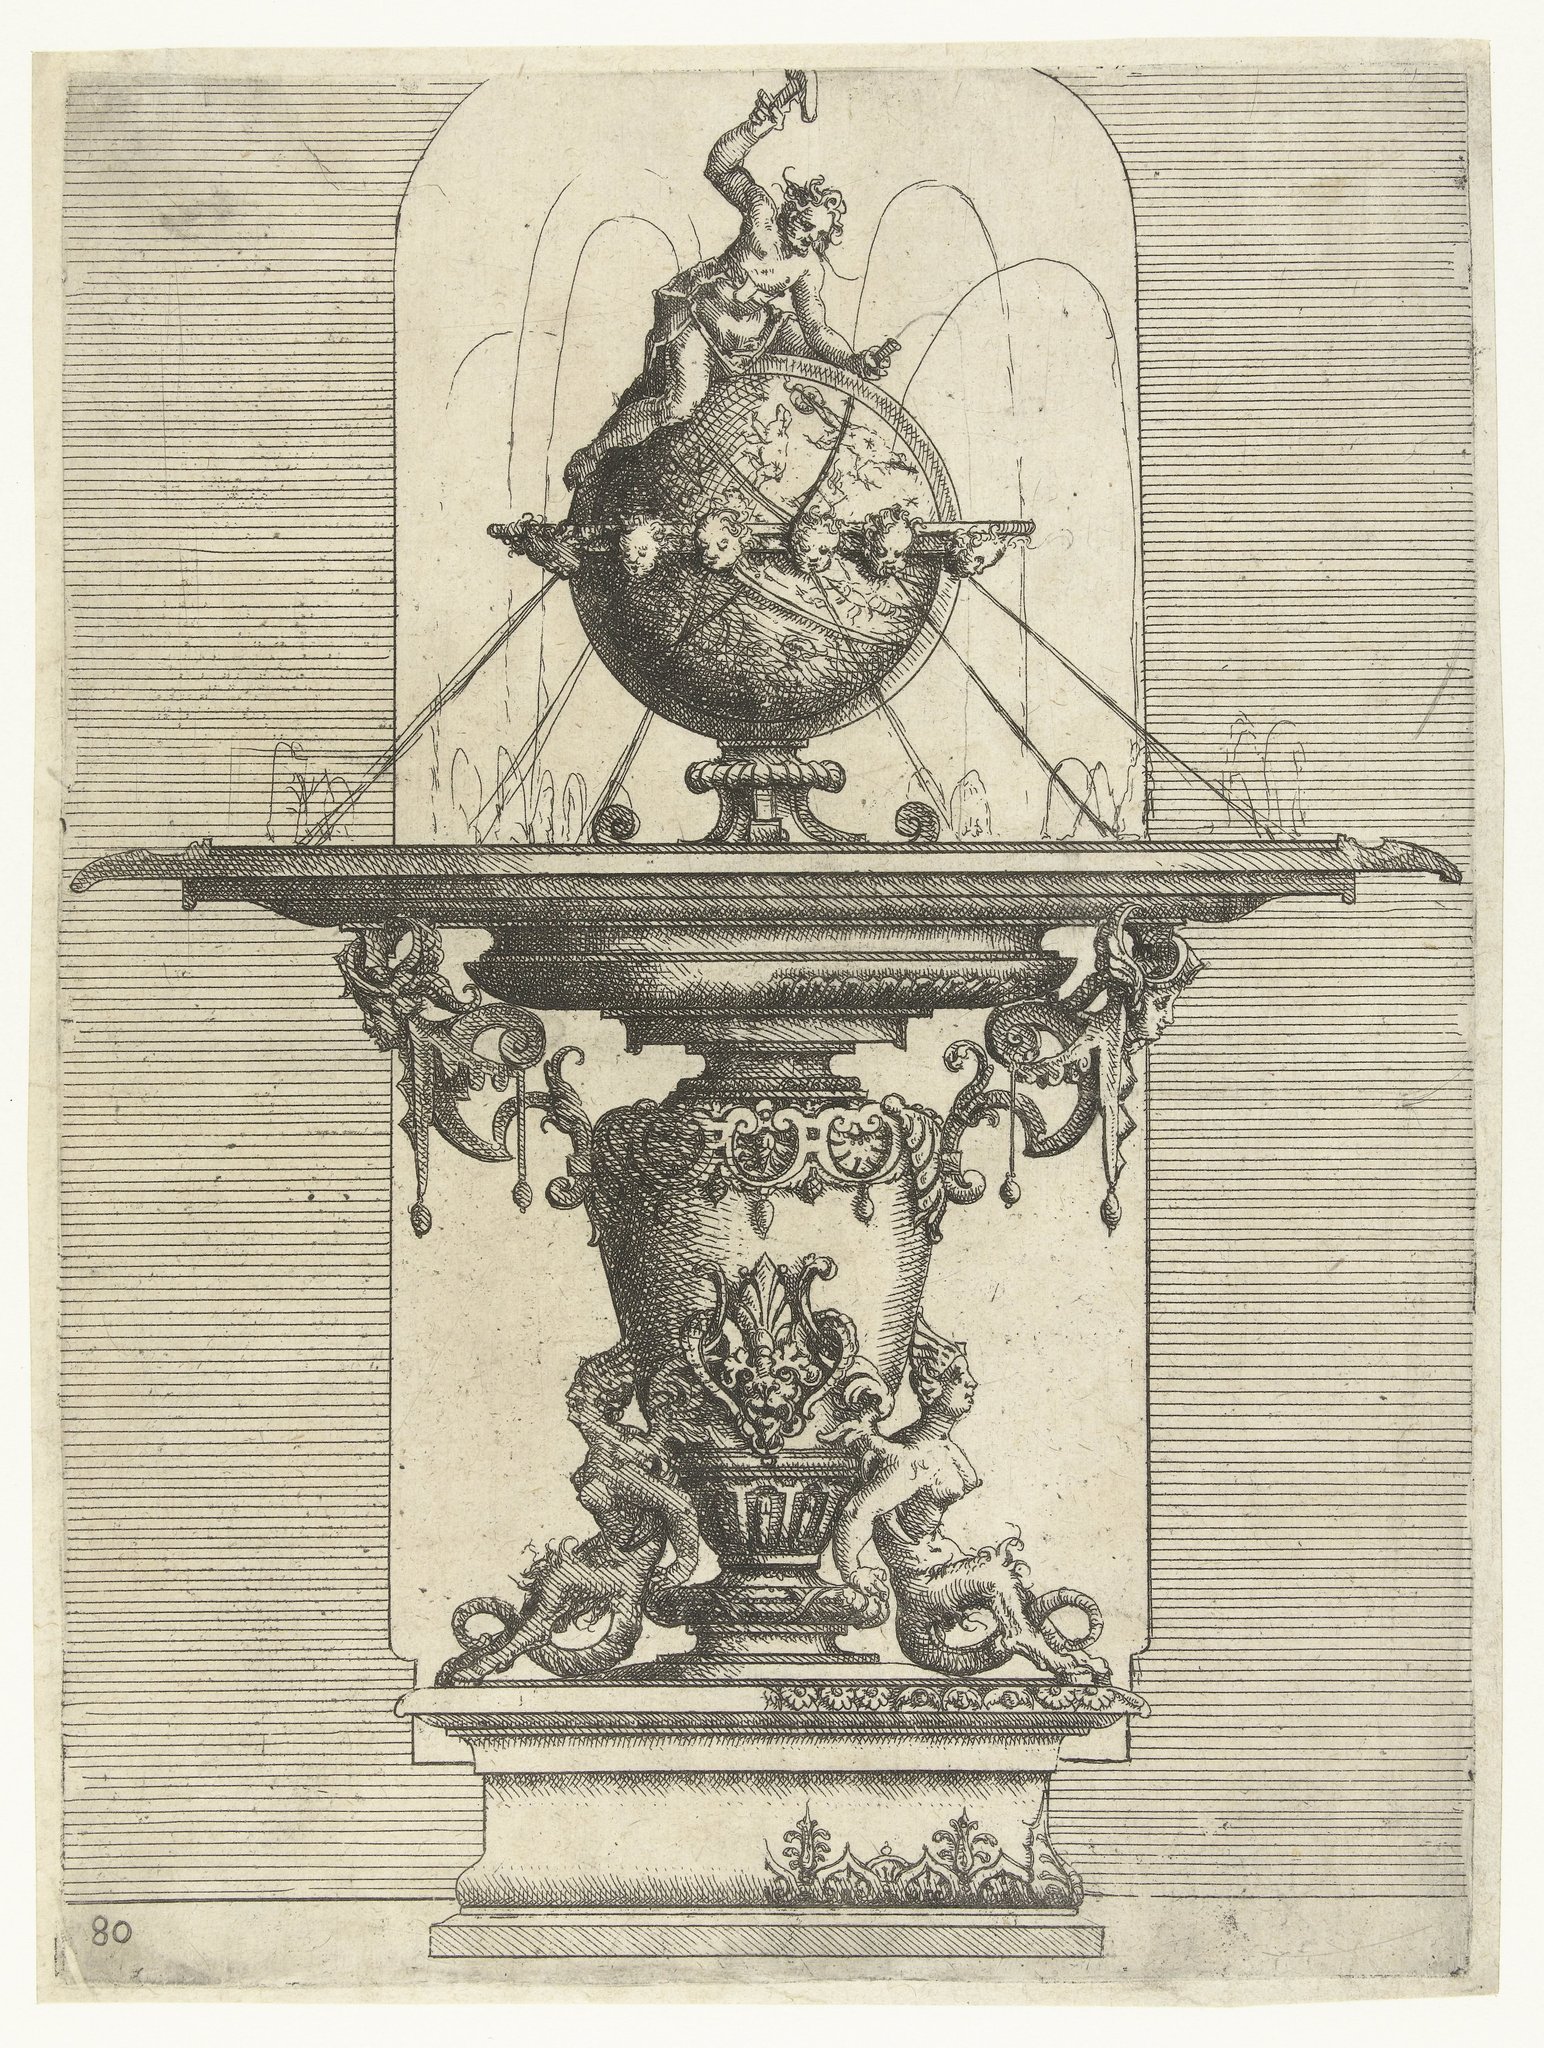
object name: print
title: Fonteinen, waterputten, schoorsteenmantels, kapitelen, vensters en retabels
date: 1560-1598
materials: paper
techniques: etching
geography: germany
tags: (story of) vulcan (hephaestus)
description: Ter weerszijden van de vaas zit een gevleugelde satervrouw. In het bekken staat een globe, gedecoreerd met waterspuwende kinderkopjes. Op de globe zit Vulcanus. Eén van 20 bladen uit een serie (Architectura. Von Ausztheilung, Symmetria und Proportion der fünff Seulen...) bestaande uit 193 bladen en 5 titelbladen, verdeeld over vijf boeken. Het gaat hier om een tweede, uitgebreide editie van de onder Orn Cat I-319 beschreven serie.